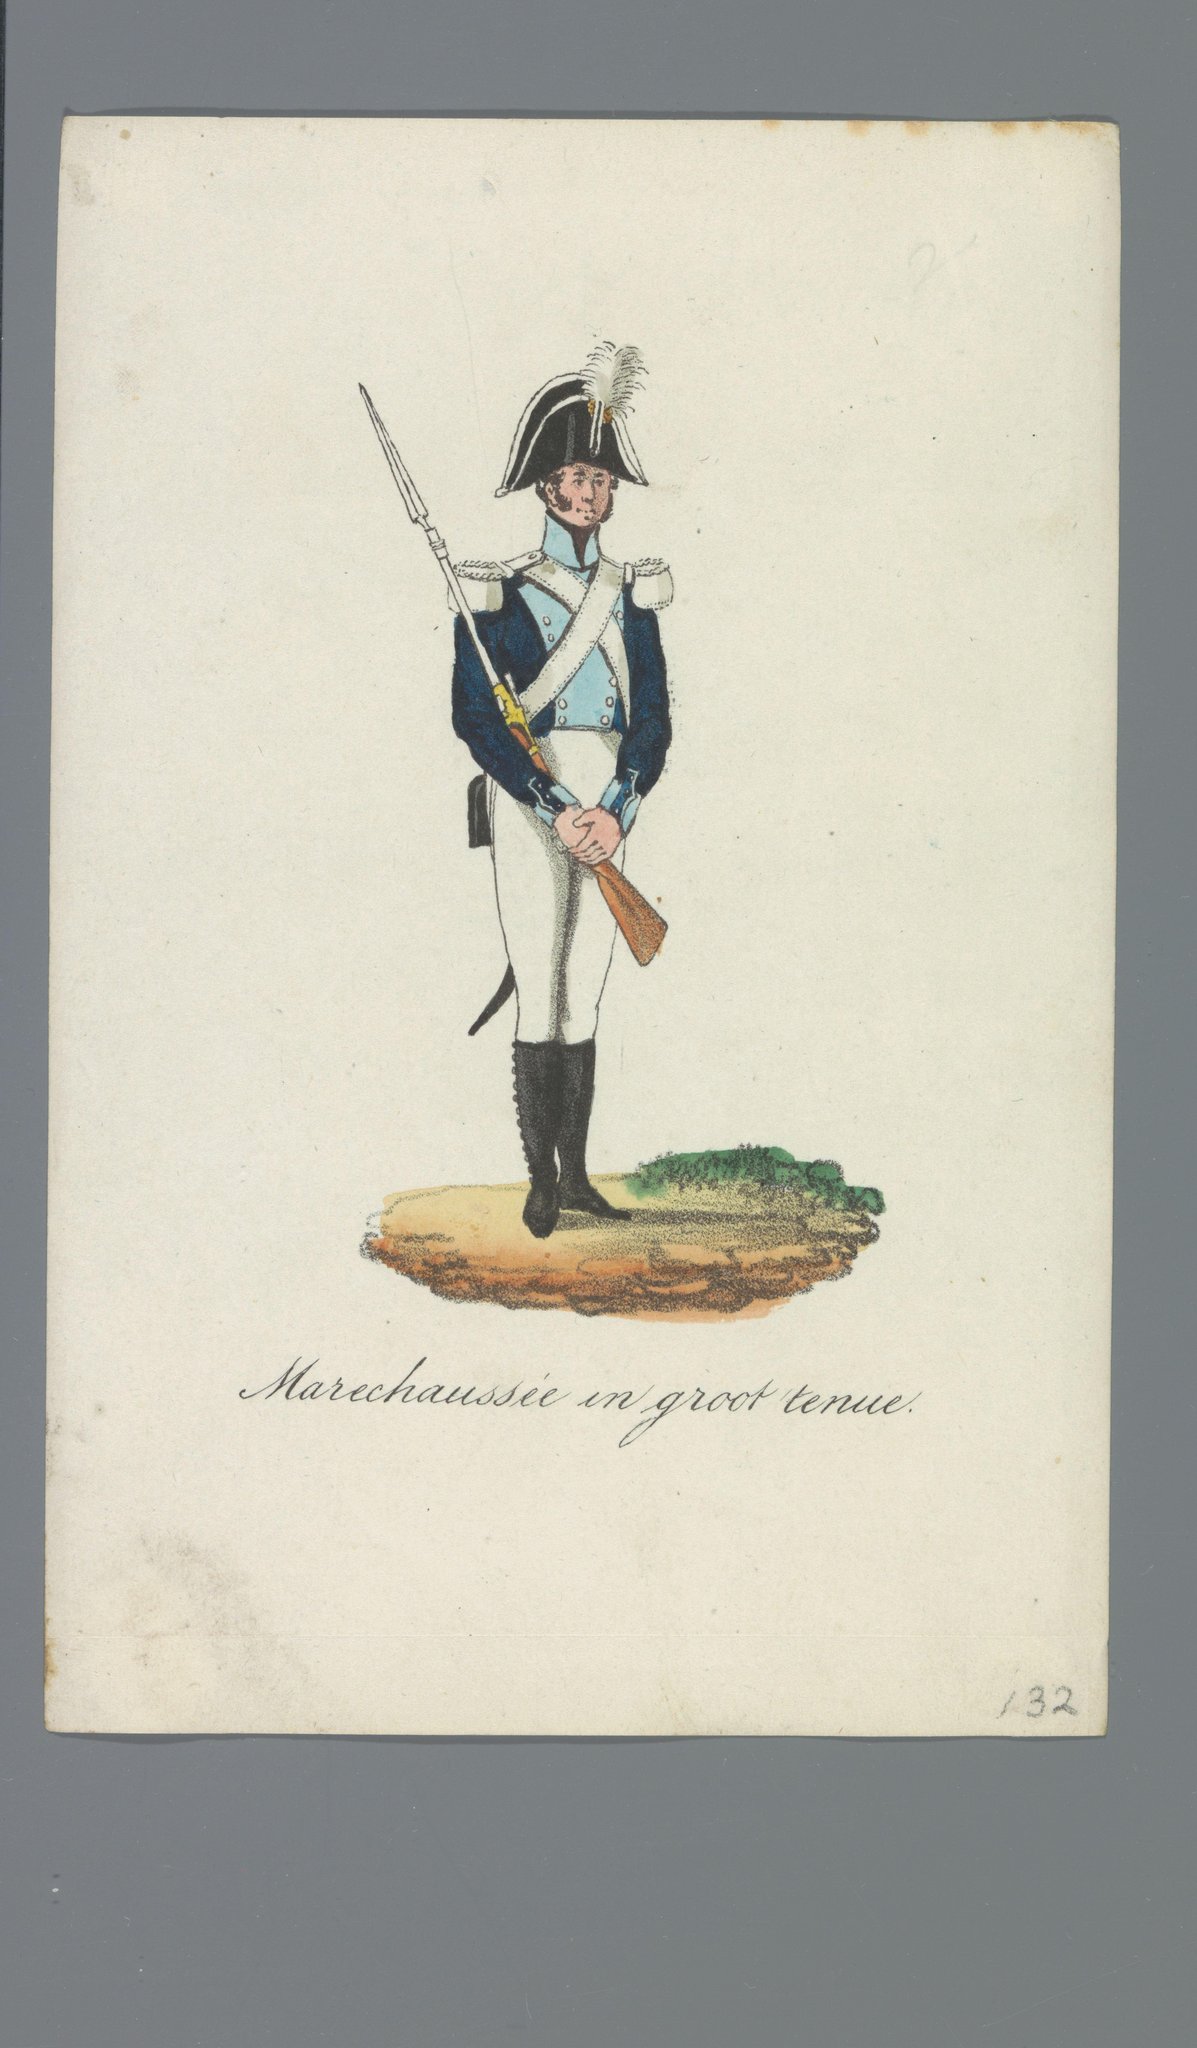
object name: print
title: Marechaussée in groot tenue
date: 1835-1850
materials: paper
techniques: hand coloring, lithograph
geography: netherlands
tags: (military) uniforms, clothes, costume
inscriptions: collector's mark: Lugt 2228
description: Een marechaussee in groot tenue, te voet. Onderdeel van een serie van 157 losse bladen met Nederlandse militaire uniformen in de jaren 1830-1832.